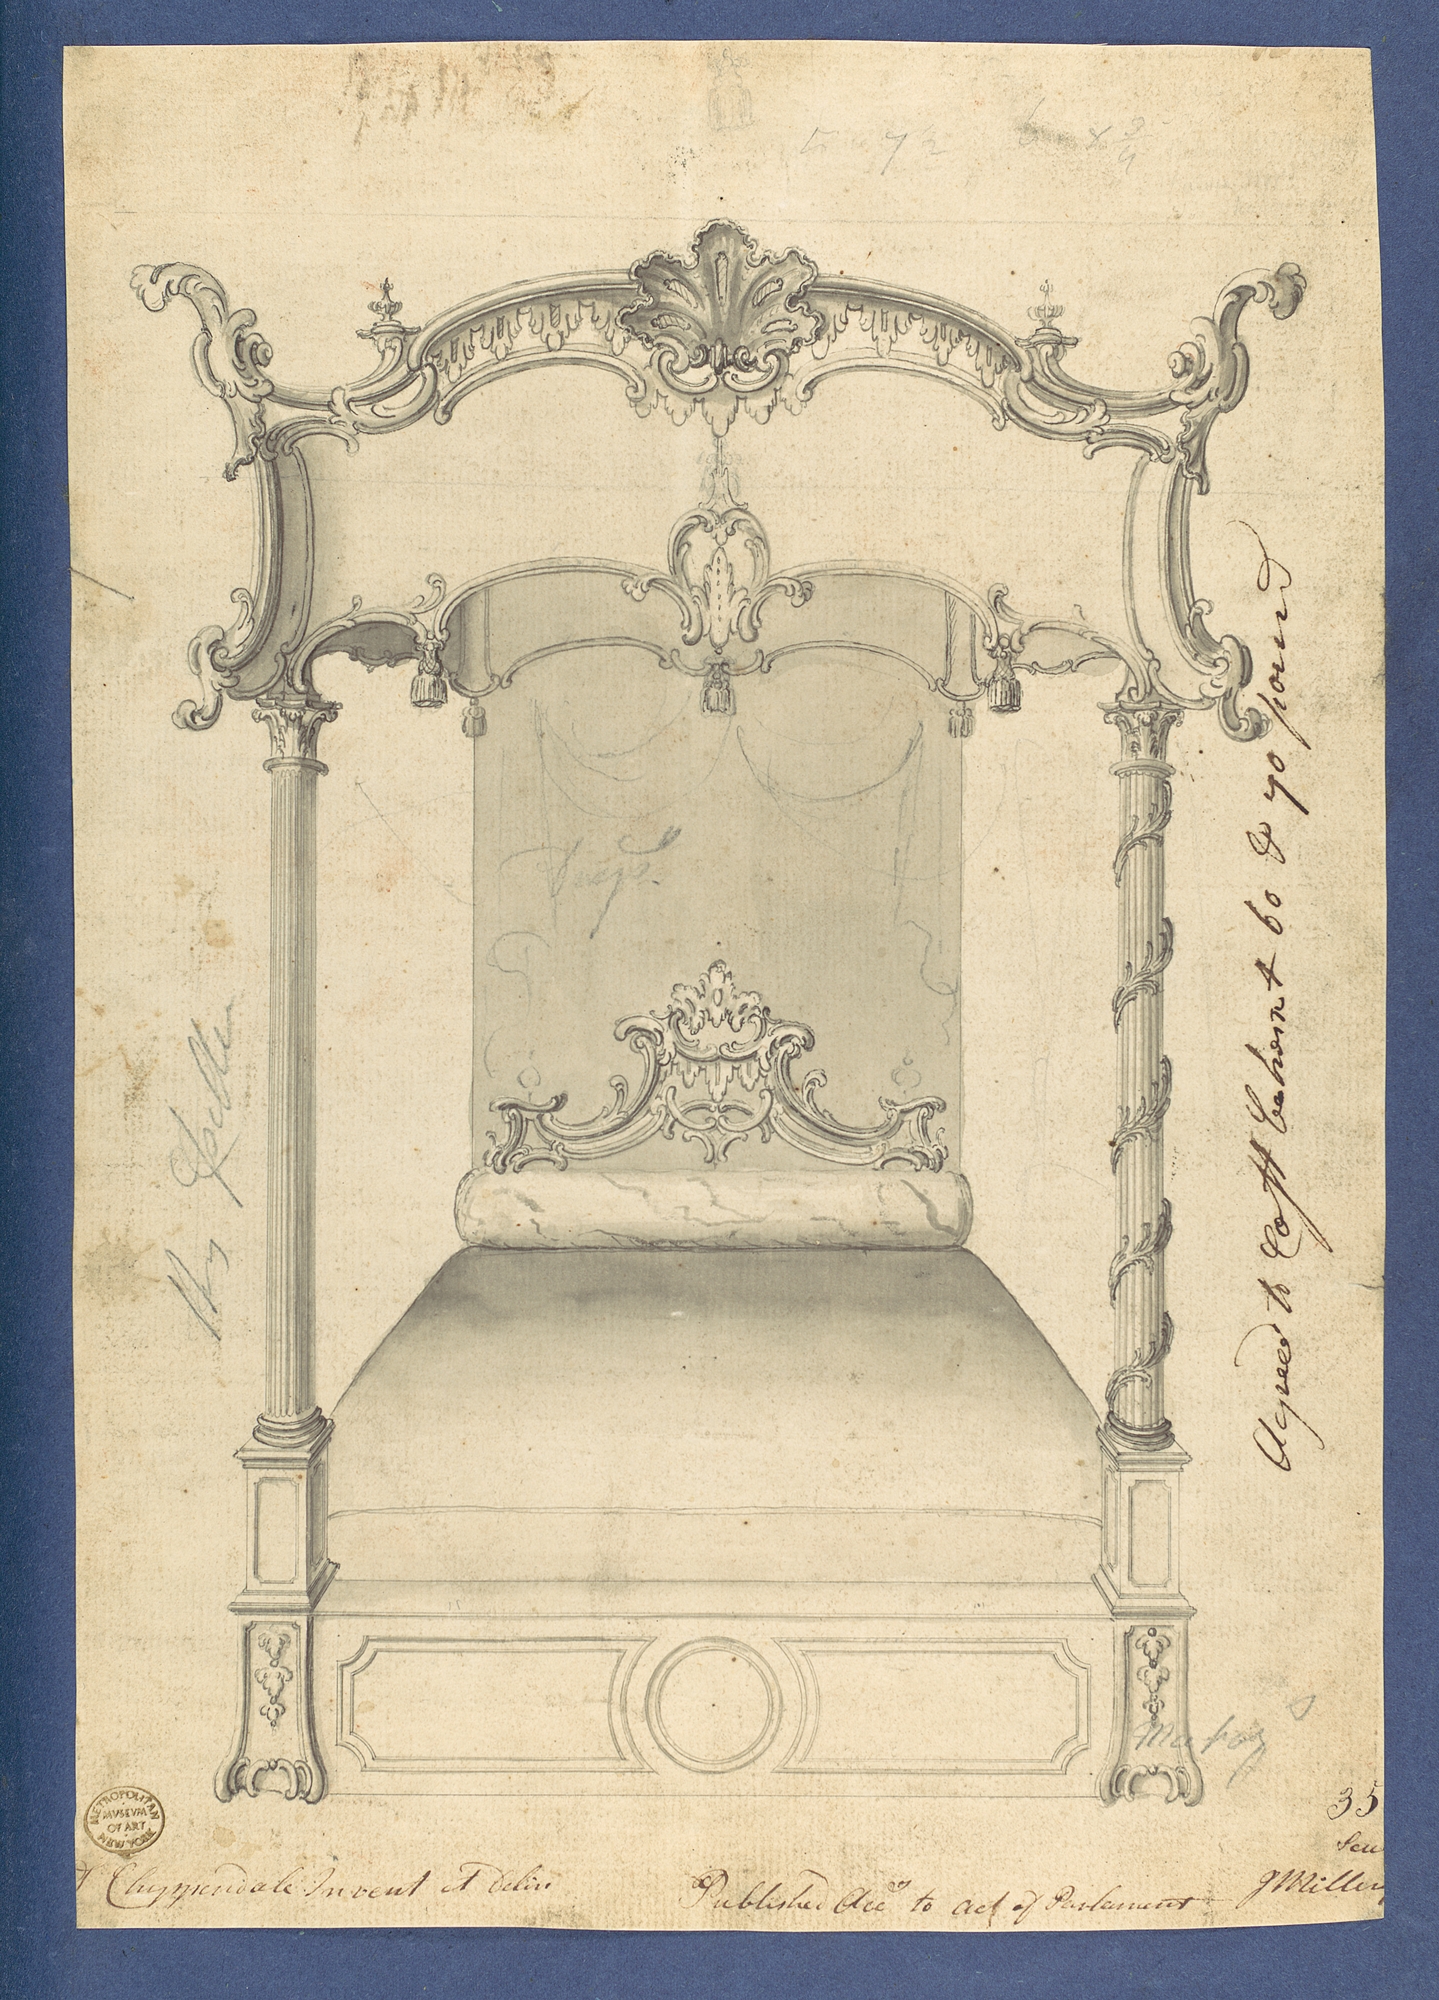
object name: drawing ornament architecture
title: Bed, in Chippendale Drawings, Vol. I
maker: thomas chippendale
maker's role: artist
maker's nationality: british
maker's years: 1718-1779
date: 1759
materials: ink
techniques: wash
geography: london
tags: beds